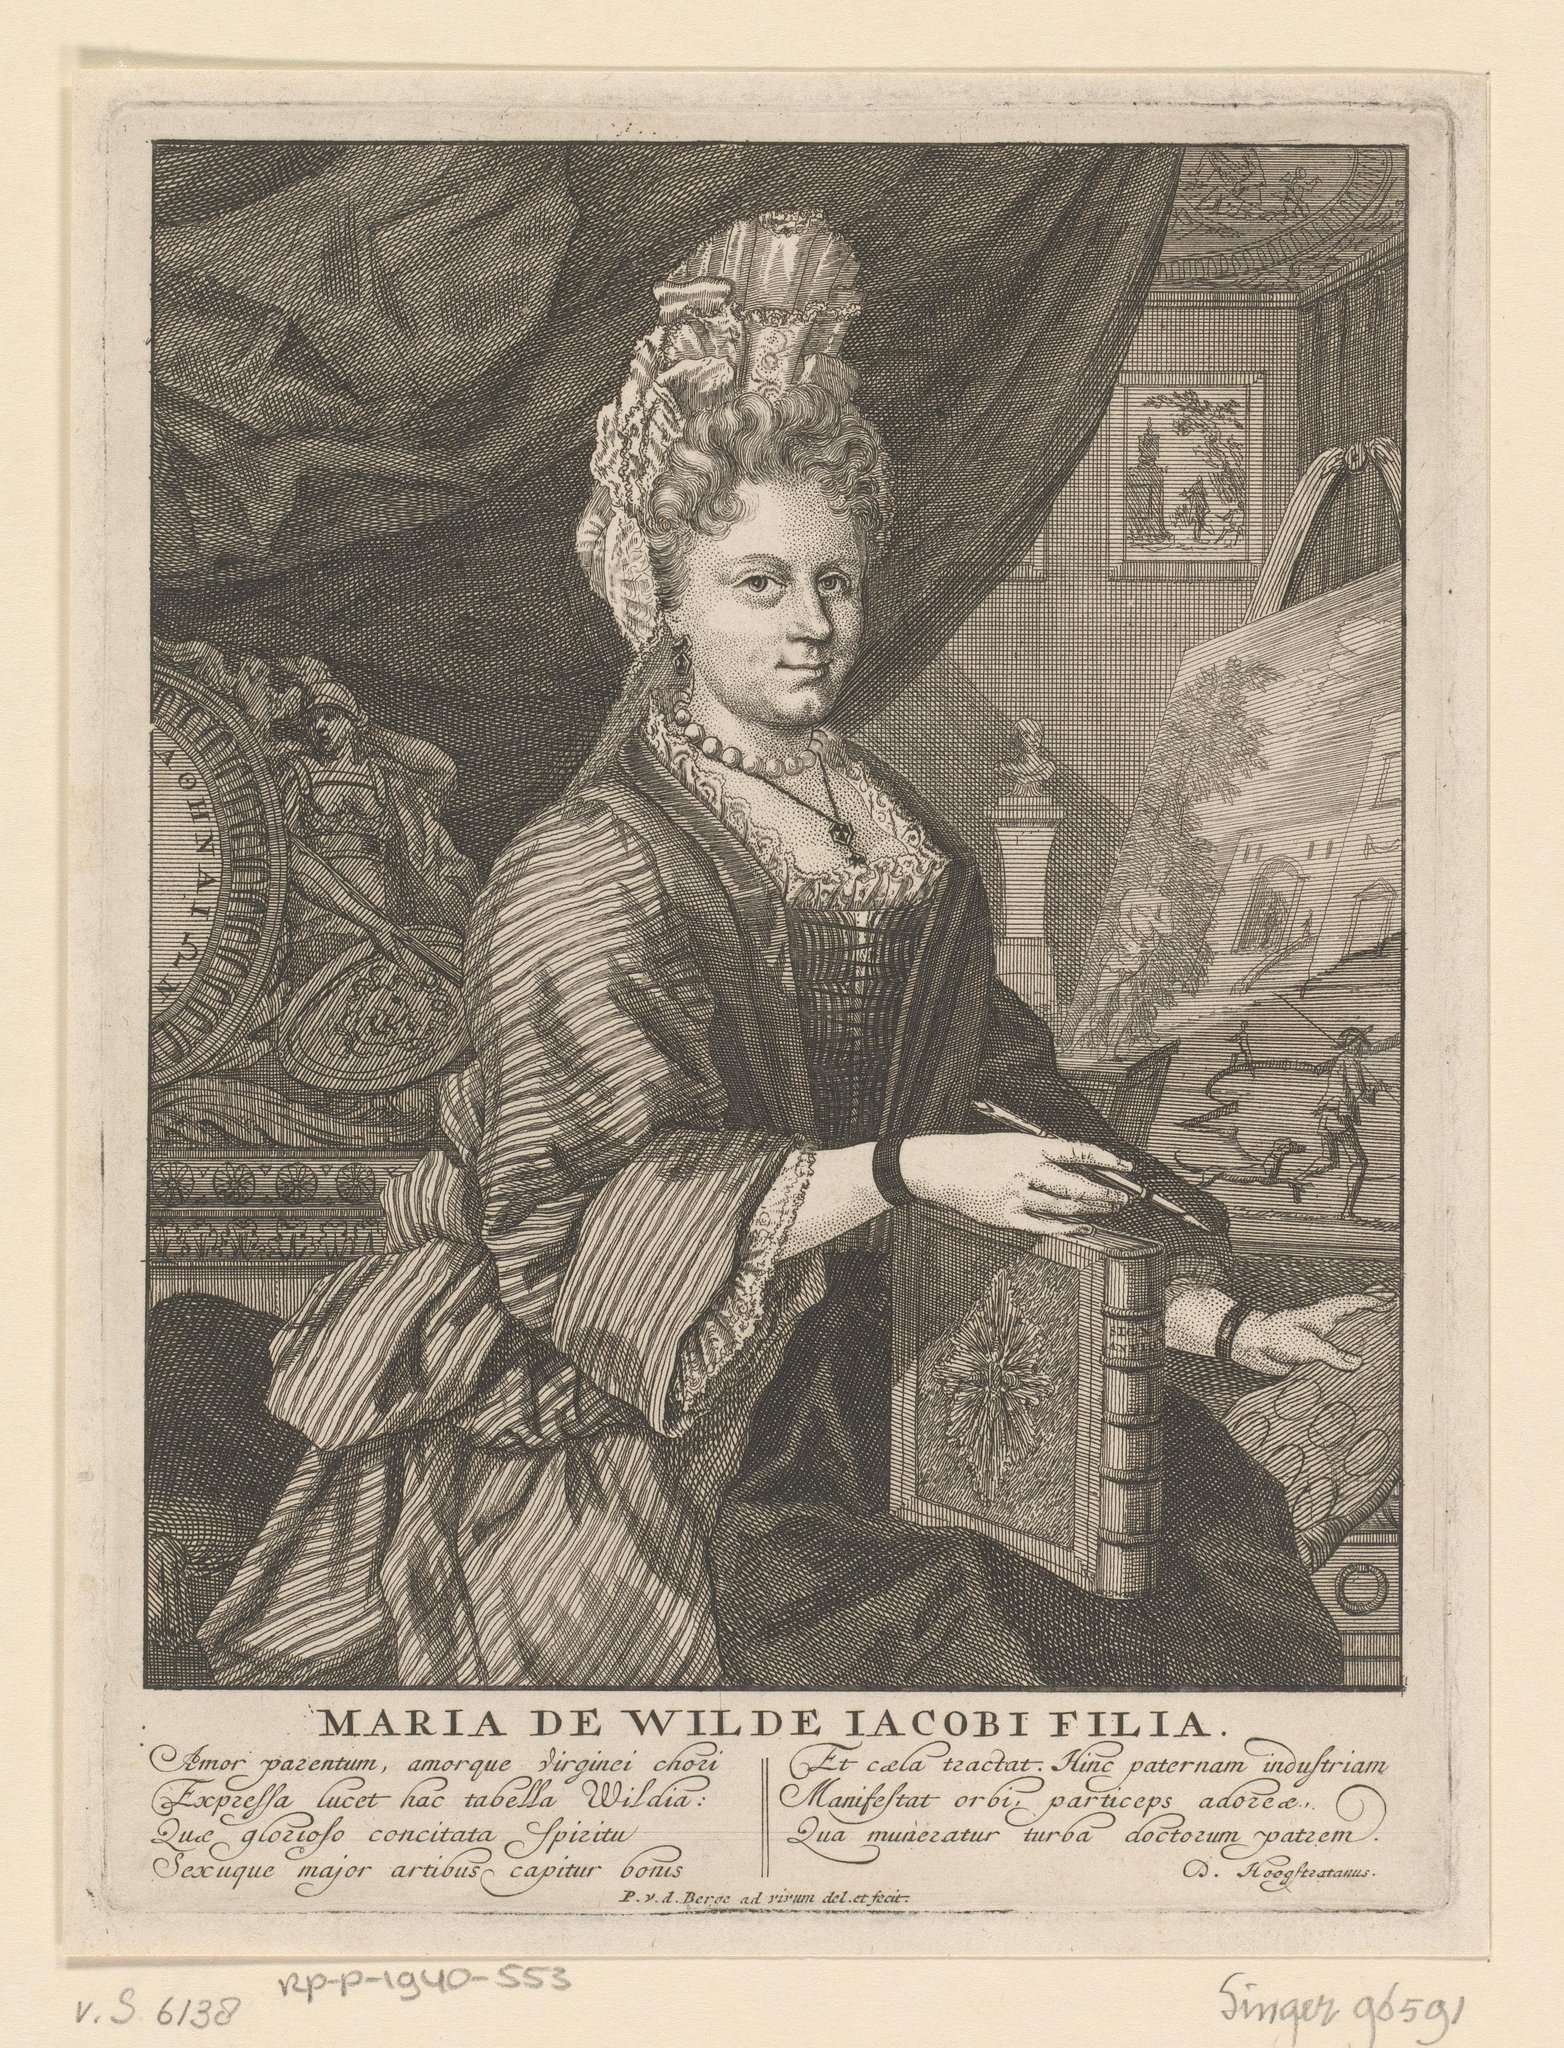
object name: print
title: Portret van Maria de Wilde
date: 1700-1730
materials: paper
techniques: etching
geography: amsterdam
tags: amsterdam, print maker, maria de wilde, historical persons - bb - woman, cabinet of curiosities, 'kunst- und wunderkammer', portrait, self-portrait of graphic artist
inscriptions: collector's mark: Lugt 2228, collector's mark: Lugt 2760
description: Zevenregelig vers in het Latijn in twee kolommen.